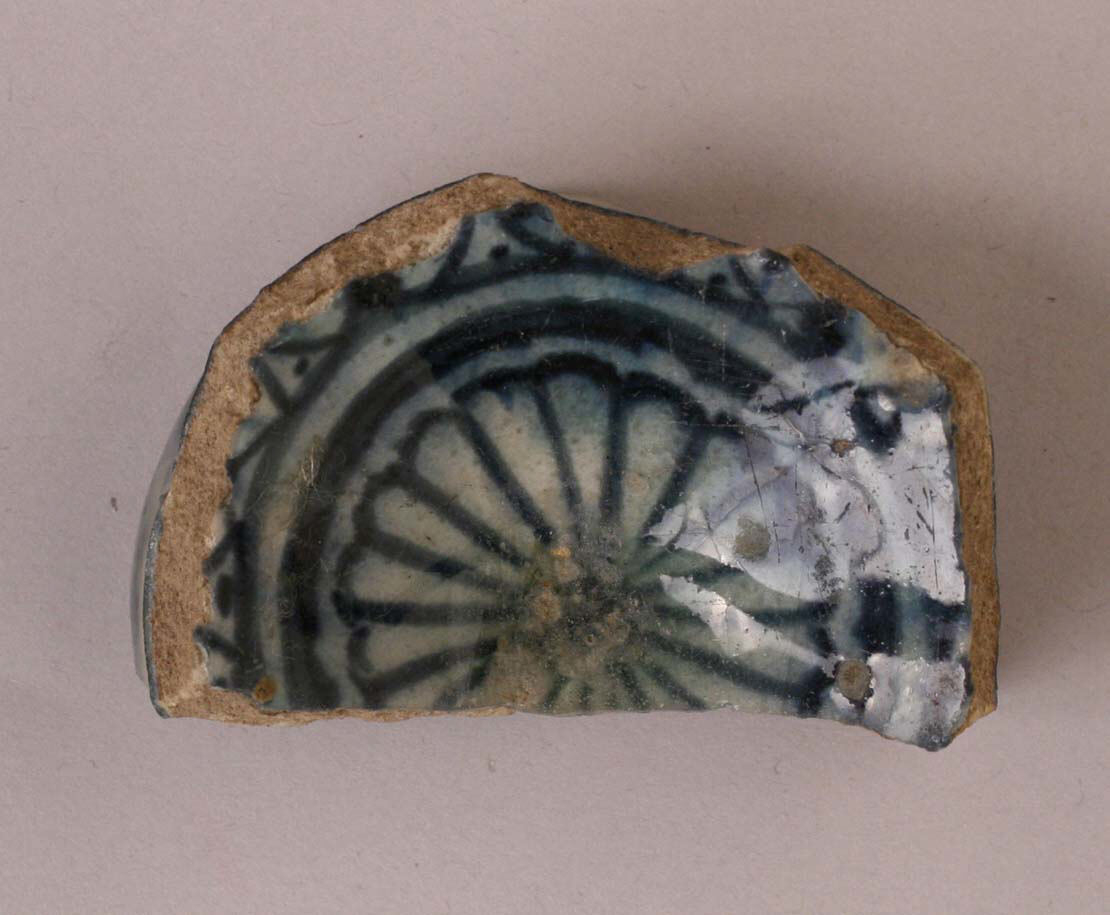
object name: fragment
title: Fragment of a Bowl or Cup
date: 1201-1600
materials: glaze, stonepaste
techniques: painting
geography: egypt